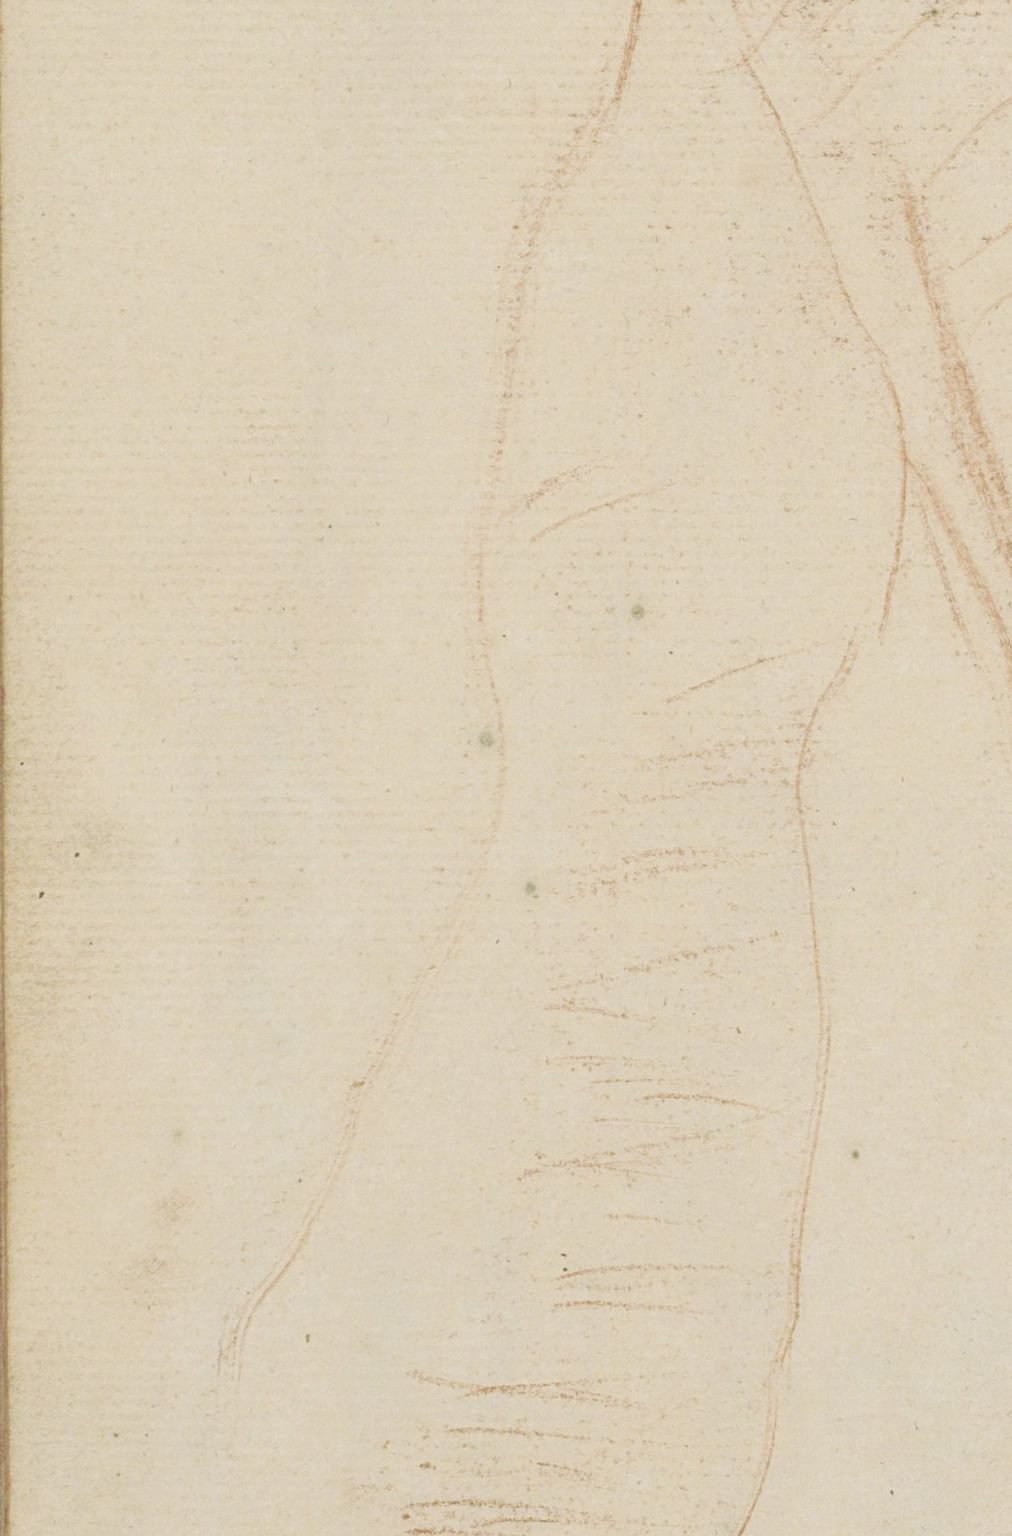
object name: sketchbook leaf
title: Hand die een stok vasthoudt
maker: petrus johannes van reysschoot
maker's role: draughtsman, print maker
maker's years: 1702-1772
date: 1710-1772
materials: chalk, paper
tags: hand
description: Blad 77 verso uit een schetsboek met 105 bladen.